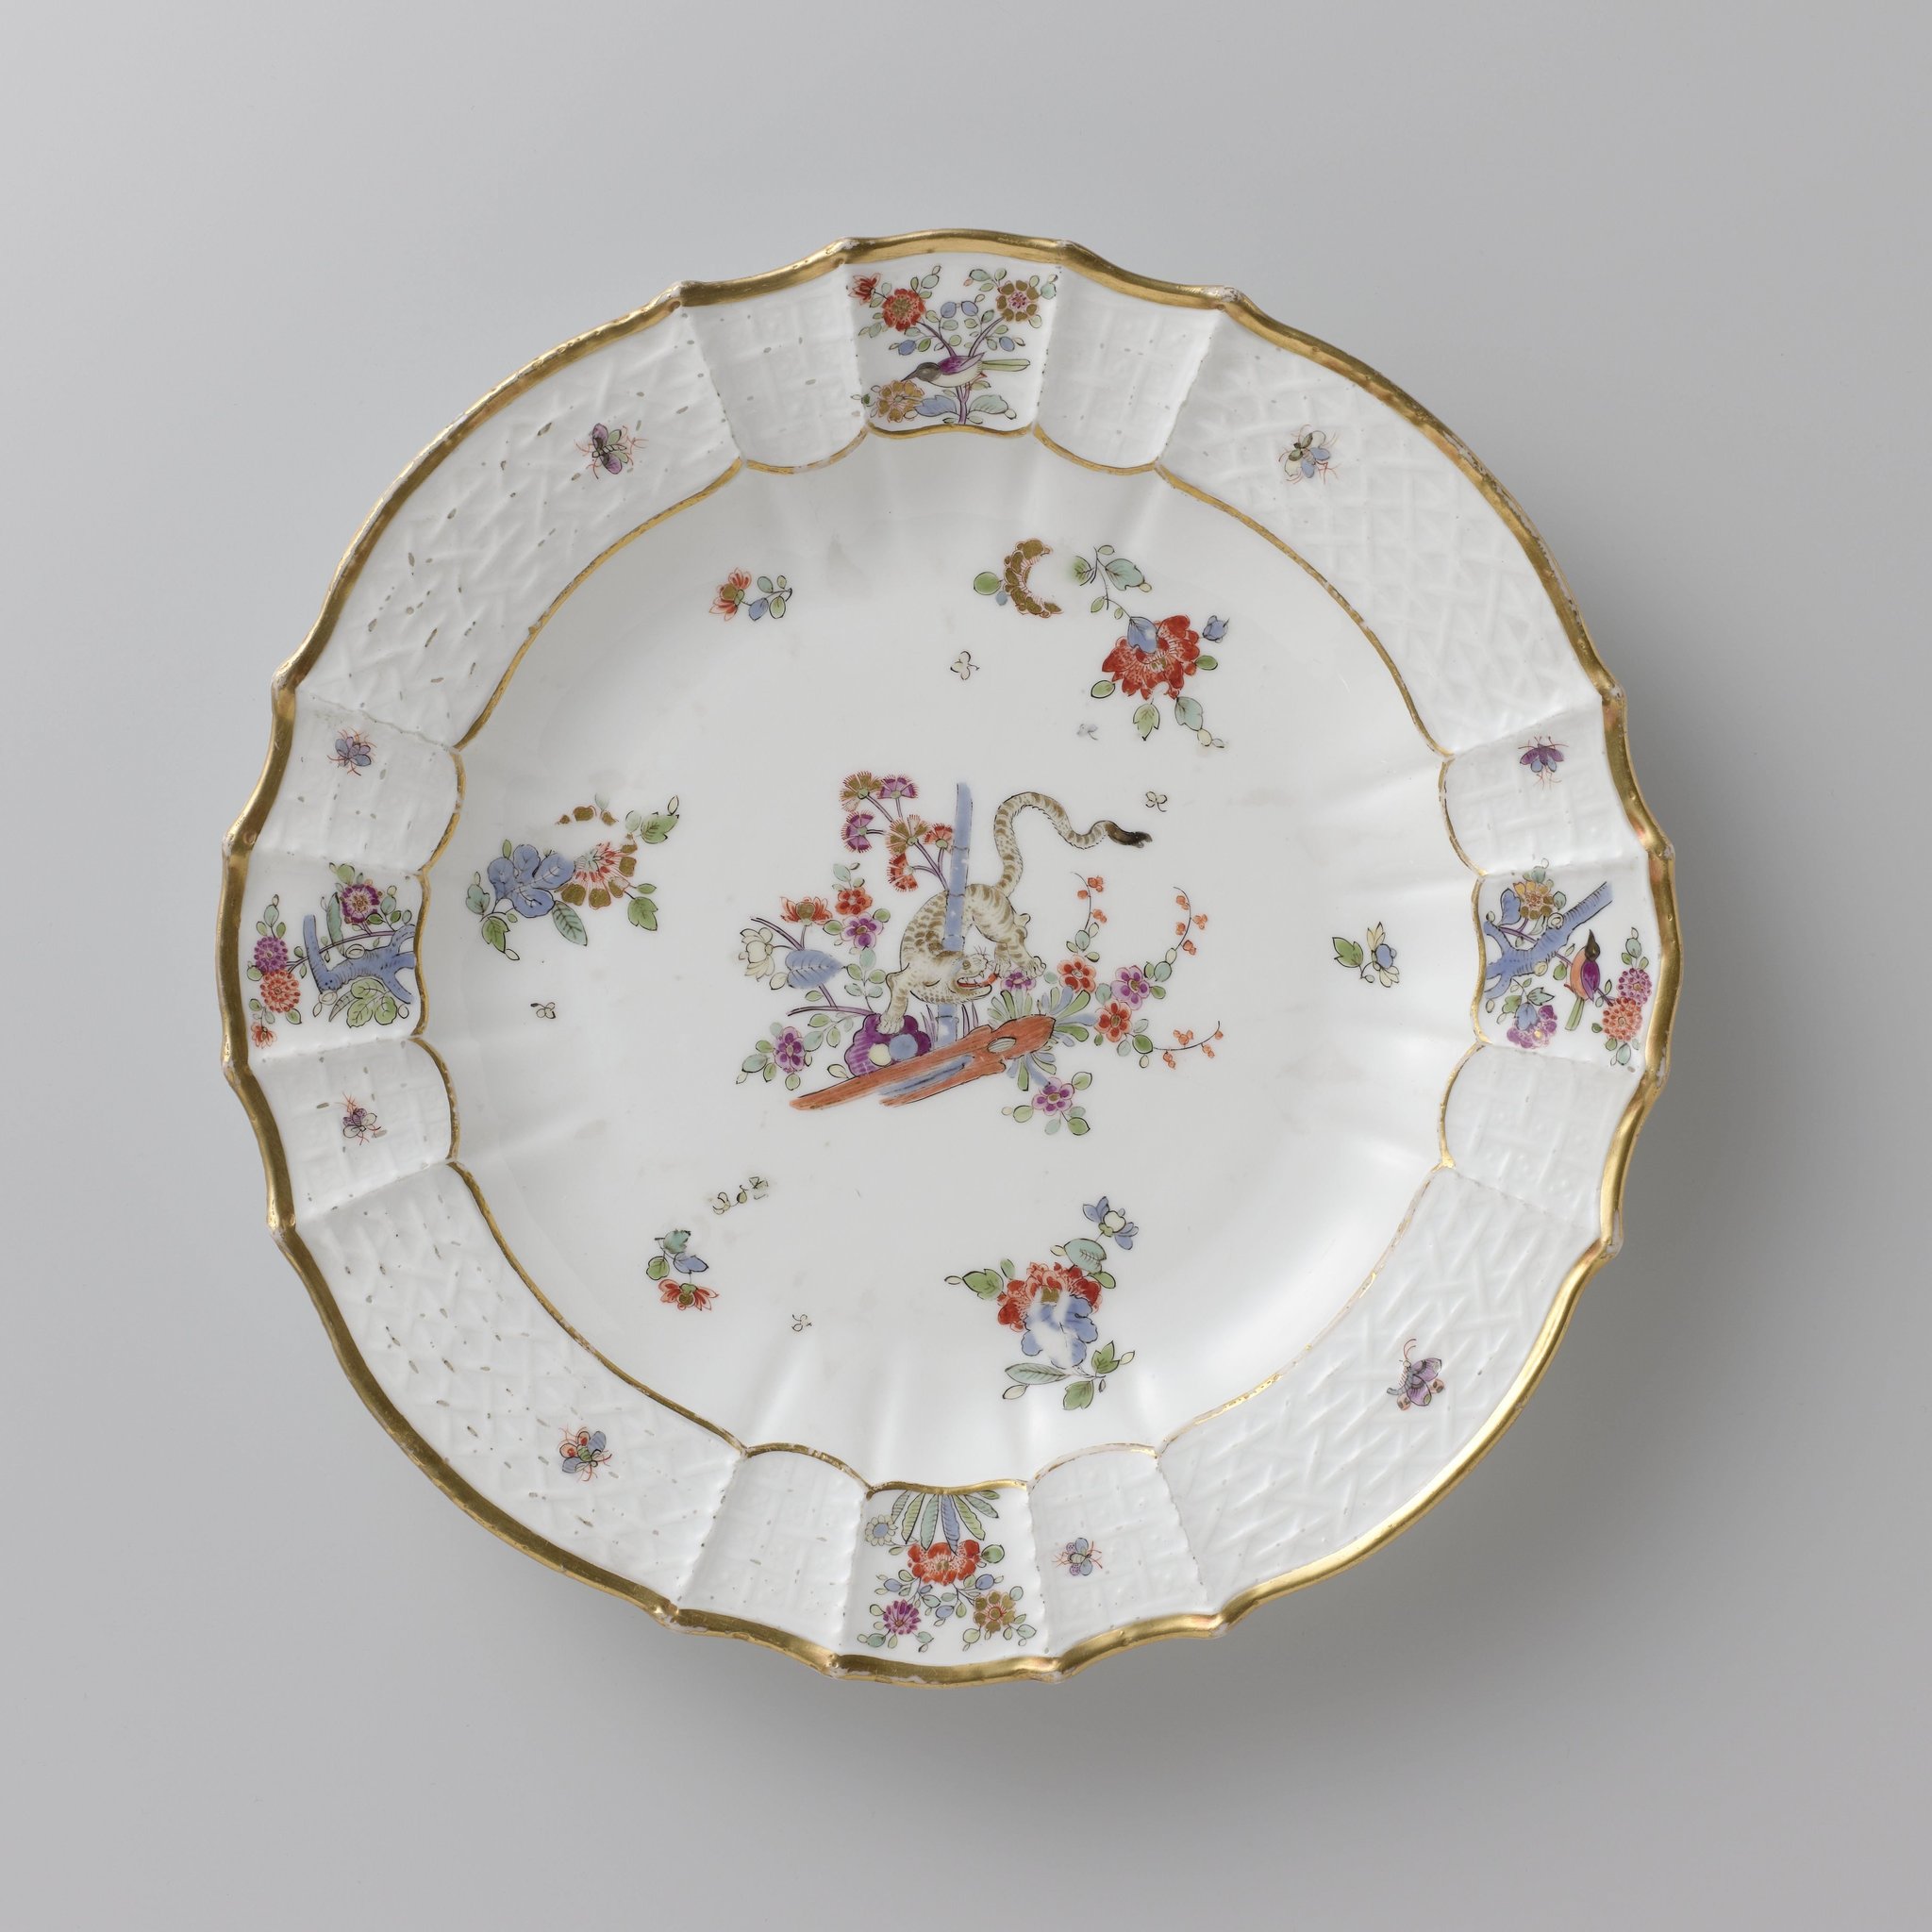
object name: plate dish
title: Rond bord, veelkleurig beschilderd met een Kakiemon-decor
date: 1740-1745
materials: porcelain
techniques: painted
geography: meissen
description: Rond bord van beschilderd porselein. Het bord is geribd en heeft een geschulpte rand. Het bord is beschilderd met een tijger die om een blauwe bamboestengel tussen bloemen is gedraaid, gestrooide Indianische Blumen, vlinders en takken waarop vogels. De rand is versierd met het 'Altbrandenstein'-patroon. Het bord is gemerkt.